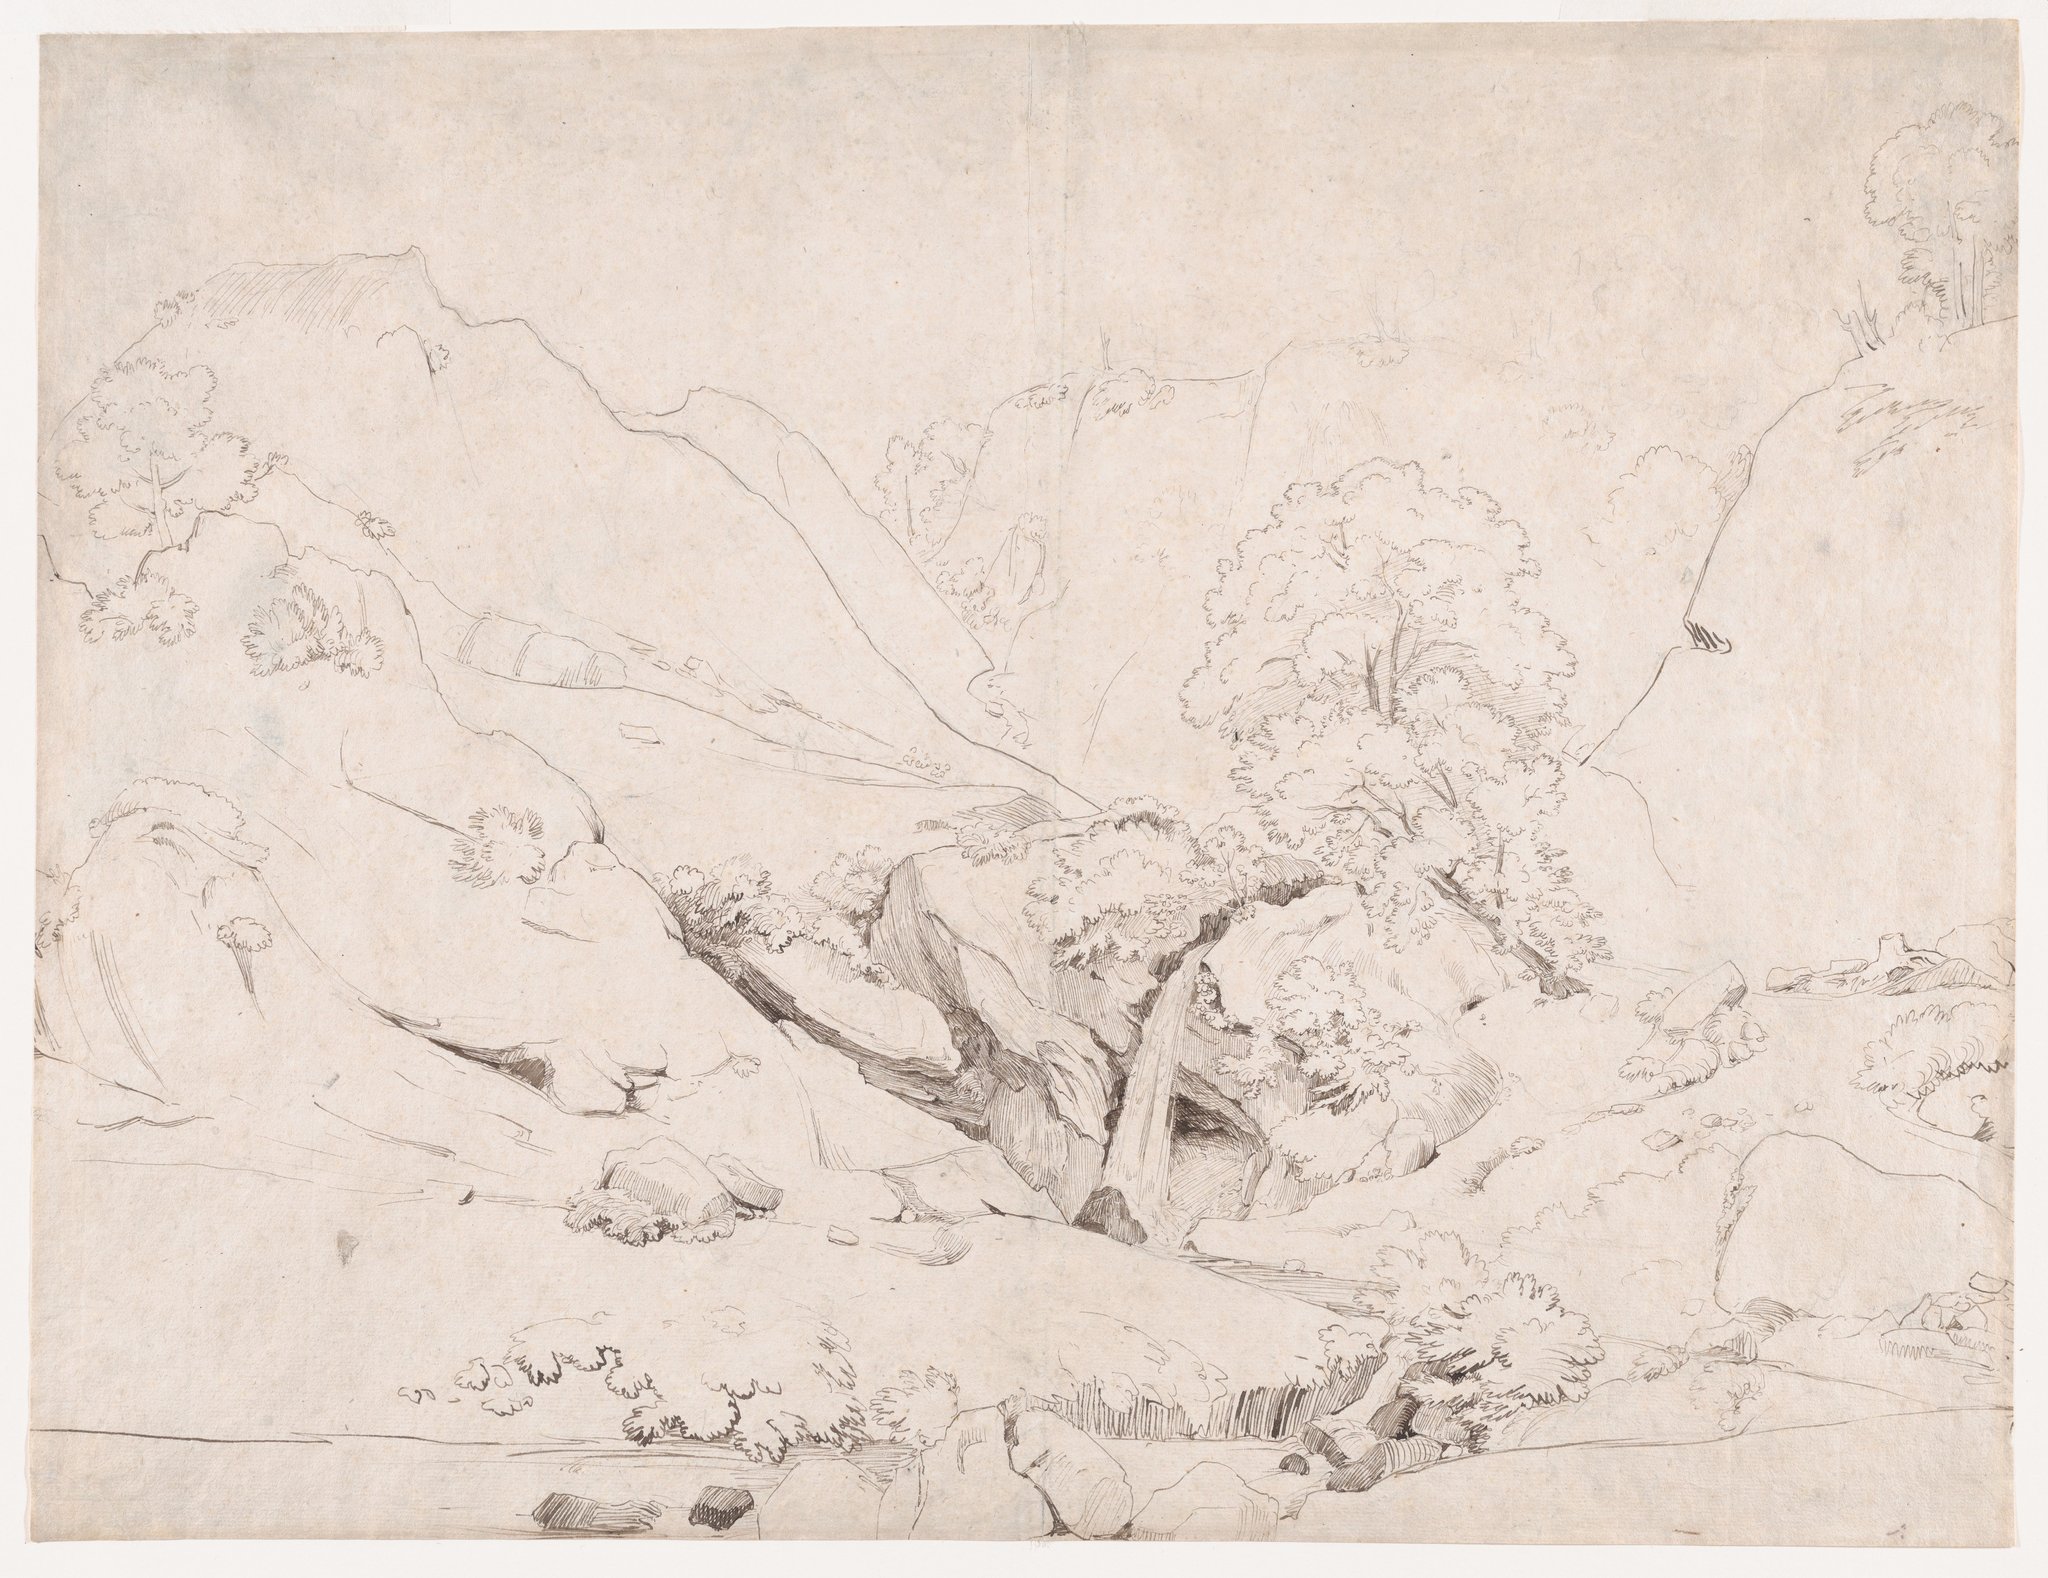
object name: drawing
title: Italian Landscape (recto); Rocks and foliage (verso)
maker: jean-baptiste-camille corot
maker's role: artist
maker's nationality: french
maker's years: 1796-1875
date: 1826-1827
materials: graphite, ink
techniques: pen